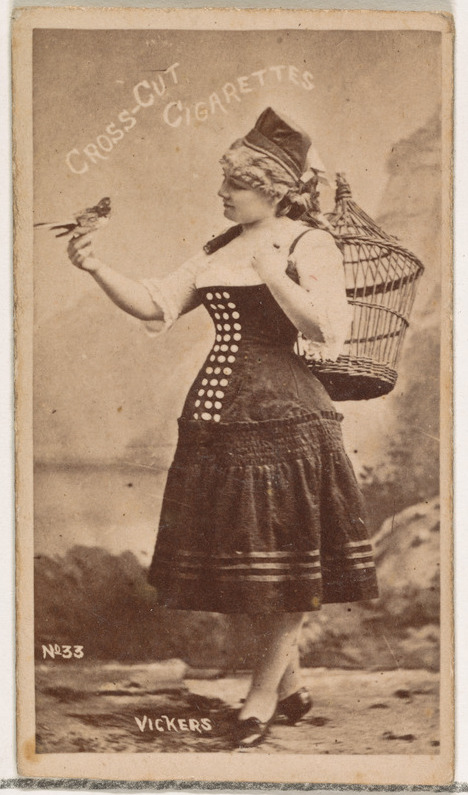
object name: print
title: Card Number 33, Vickers, from the Actors and Actresses series (N145-1) issued by Duke Sons & Co. to promote Cross Cut Cigarettes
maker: w. duke, sons & co.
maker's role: publisher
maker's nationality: american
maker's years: 1870-1920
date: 1880-1889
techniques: albumen silver print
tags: profiles,women,actresses